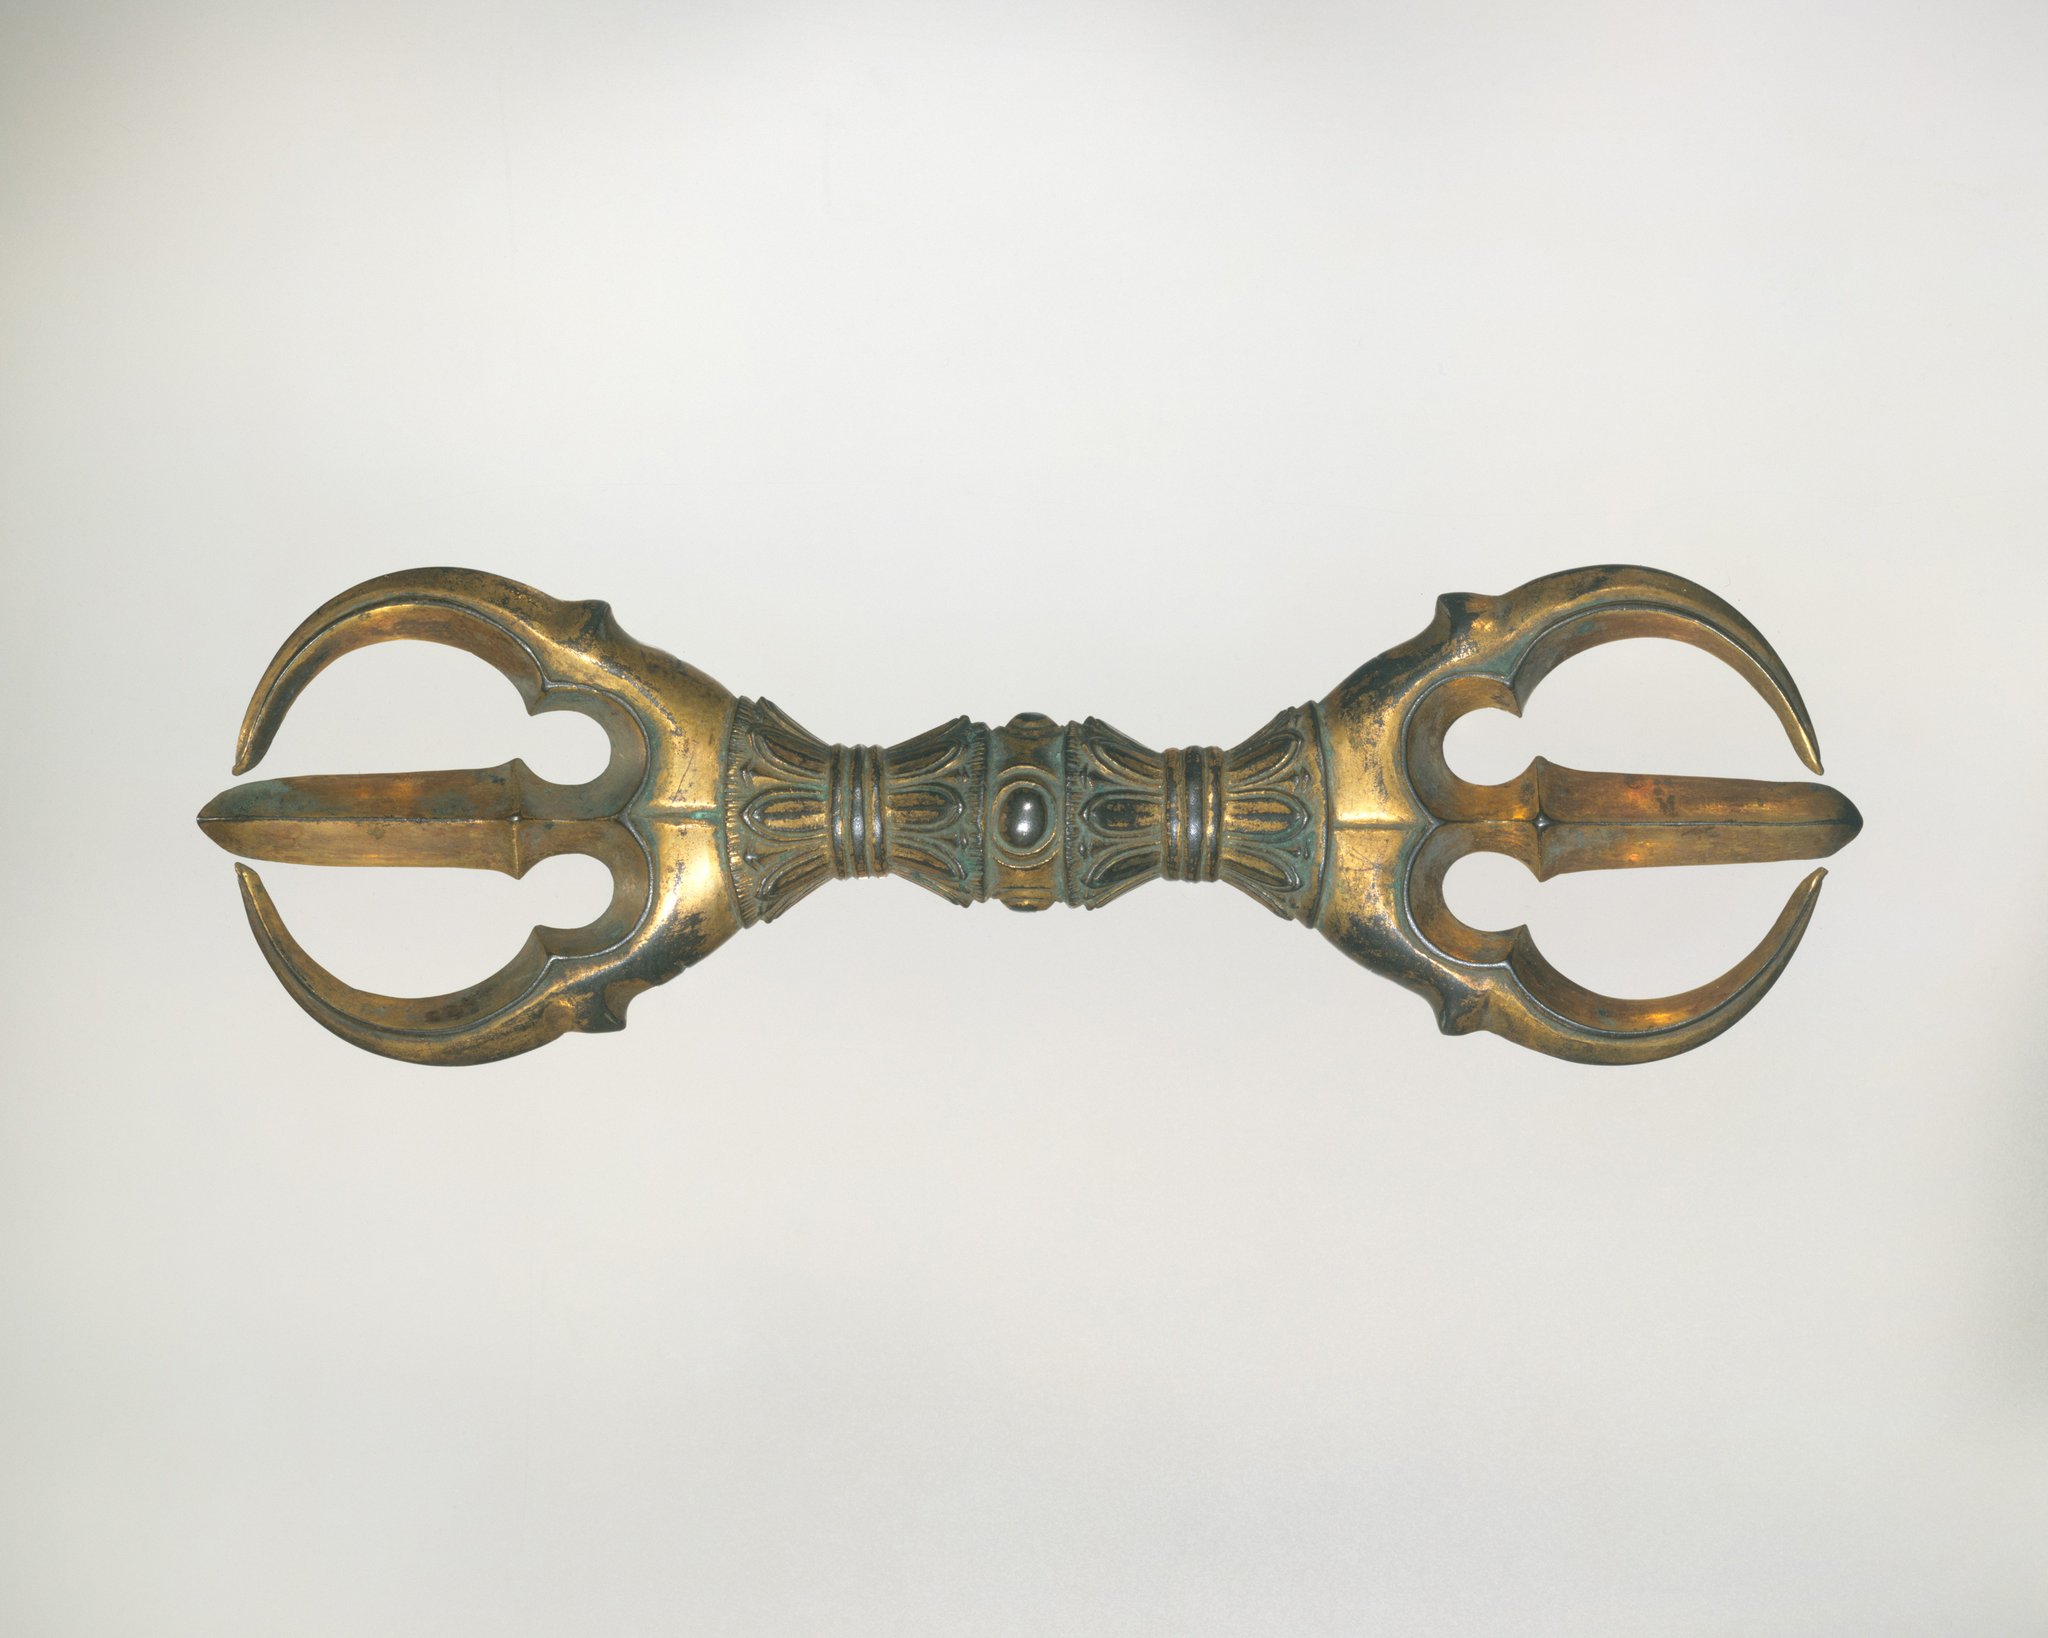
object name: vajra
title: Three-Pronged Vajra (Sankosho)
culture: japanese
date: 1101-1200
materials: gilt bronze